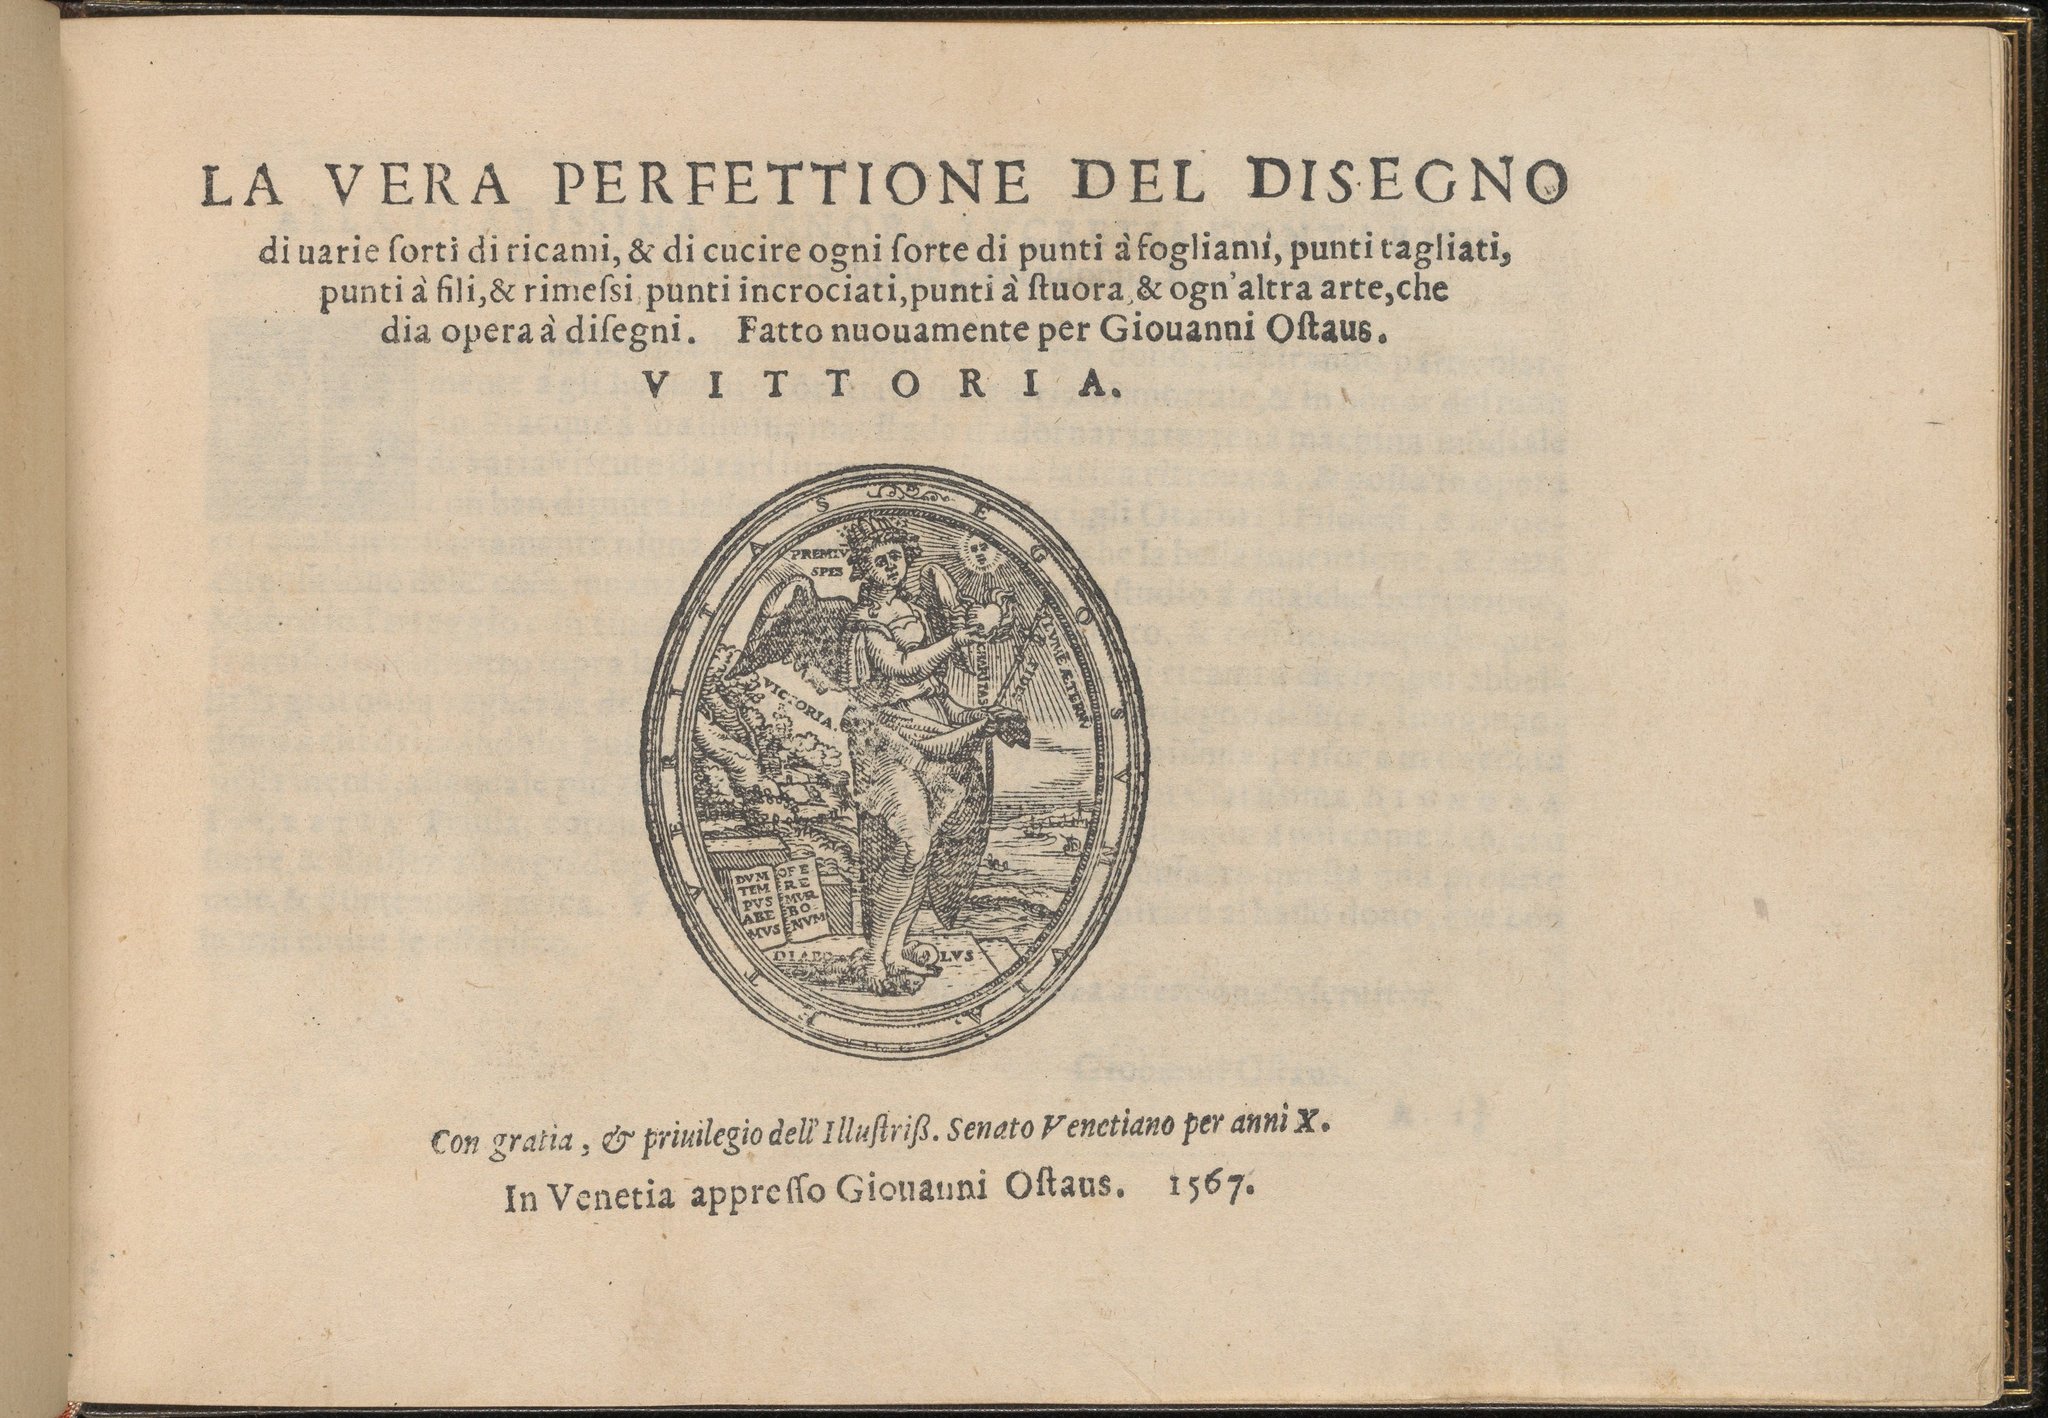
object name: book print ornament architecture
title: La Vera Perfettione del Disegno di varie sorti di recami, title page (recto)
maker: giovanni ostaus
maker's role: publisher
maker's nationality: italian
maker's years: 1507-1607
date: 1567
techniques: woodcut